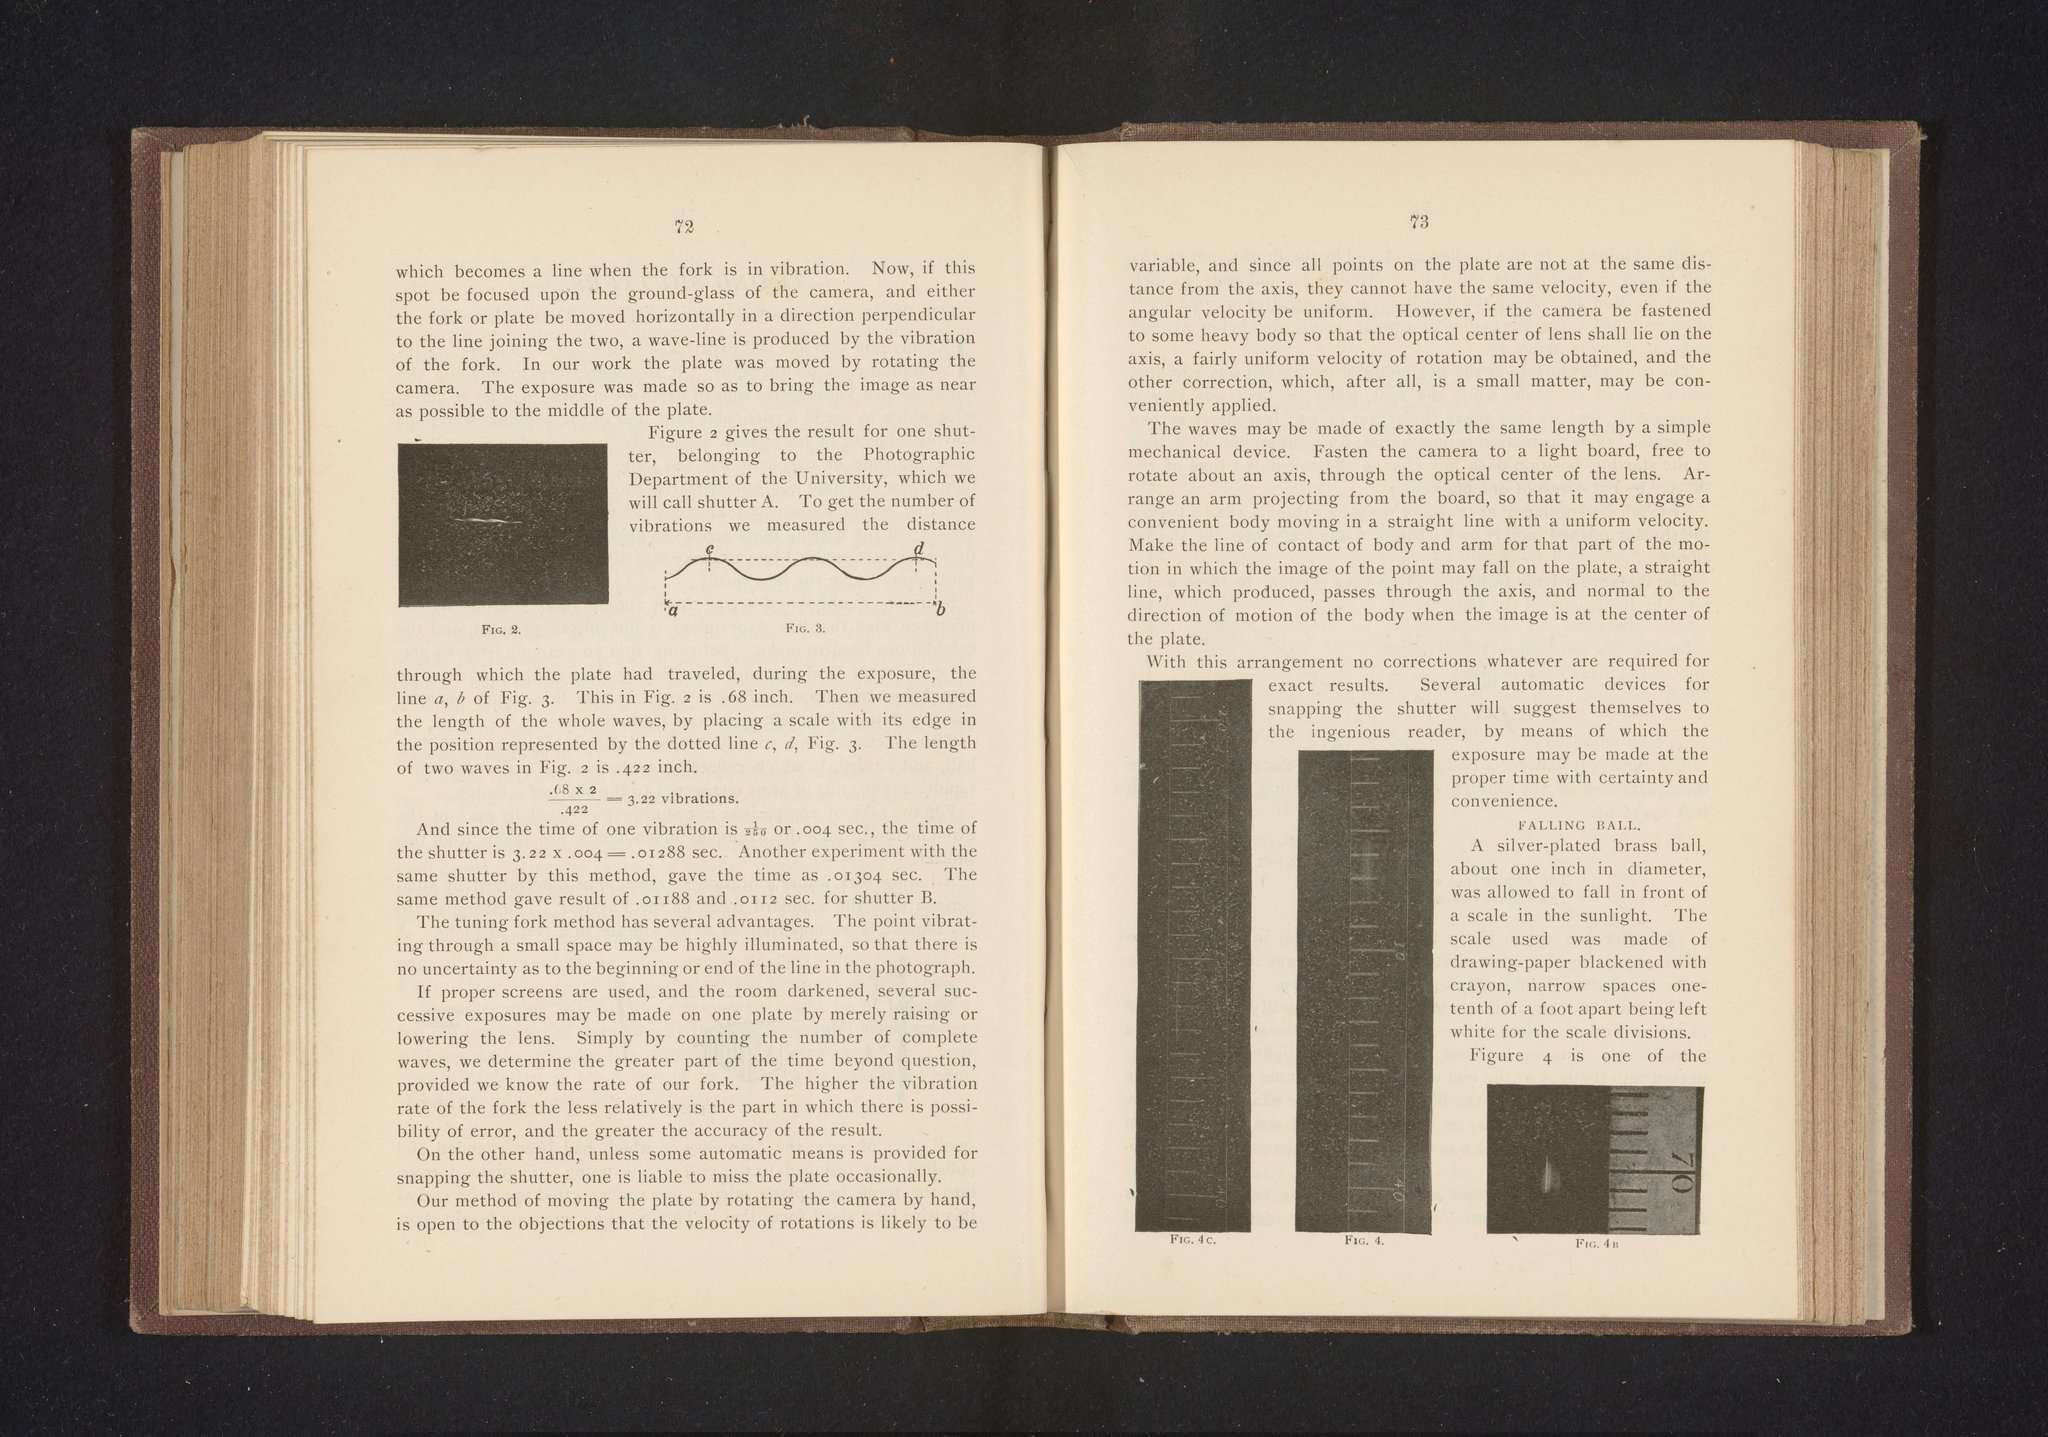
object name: page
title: Trillende stemvork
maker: Anonymous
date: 1890-1895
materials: paper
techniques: autotype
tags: accessories ~ music: metronome, music-stand, tuning-fork, etc.